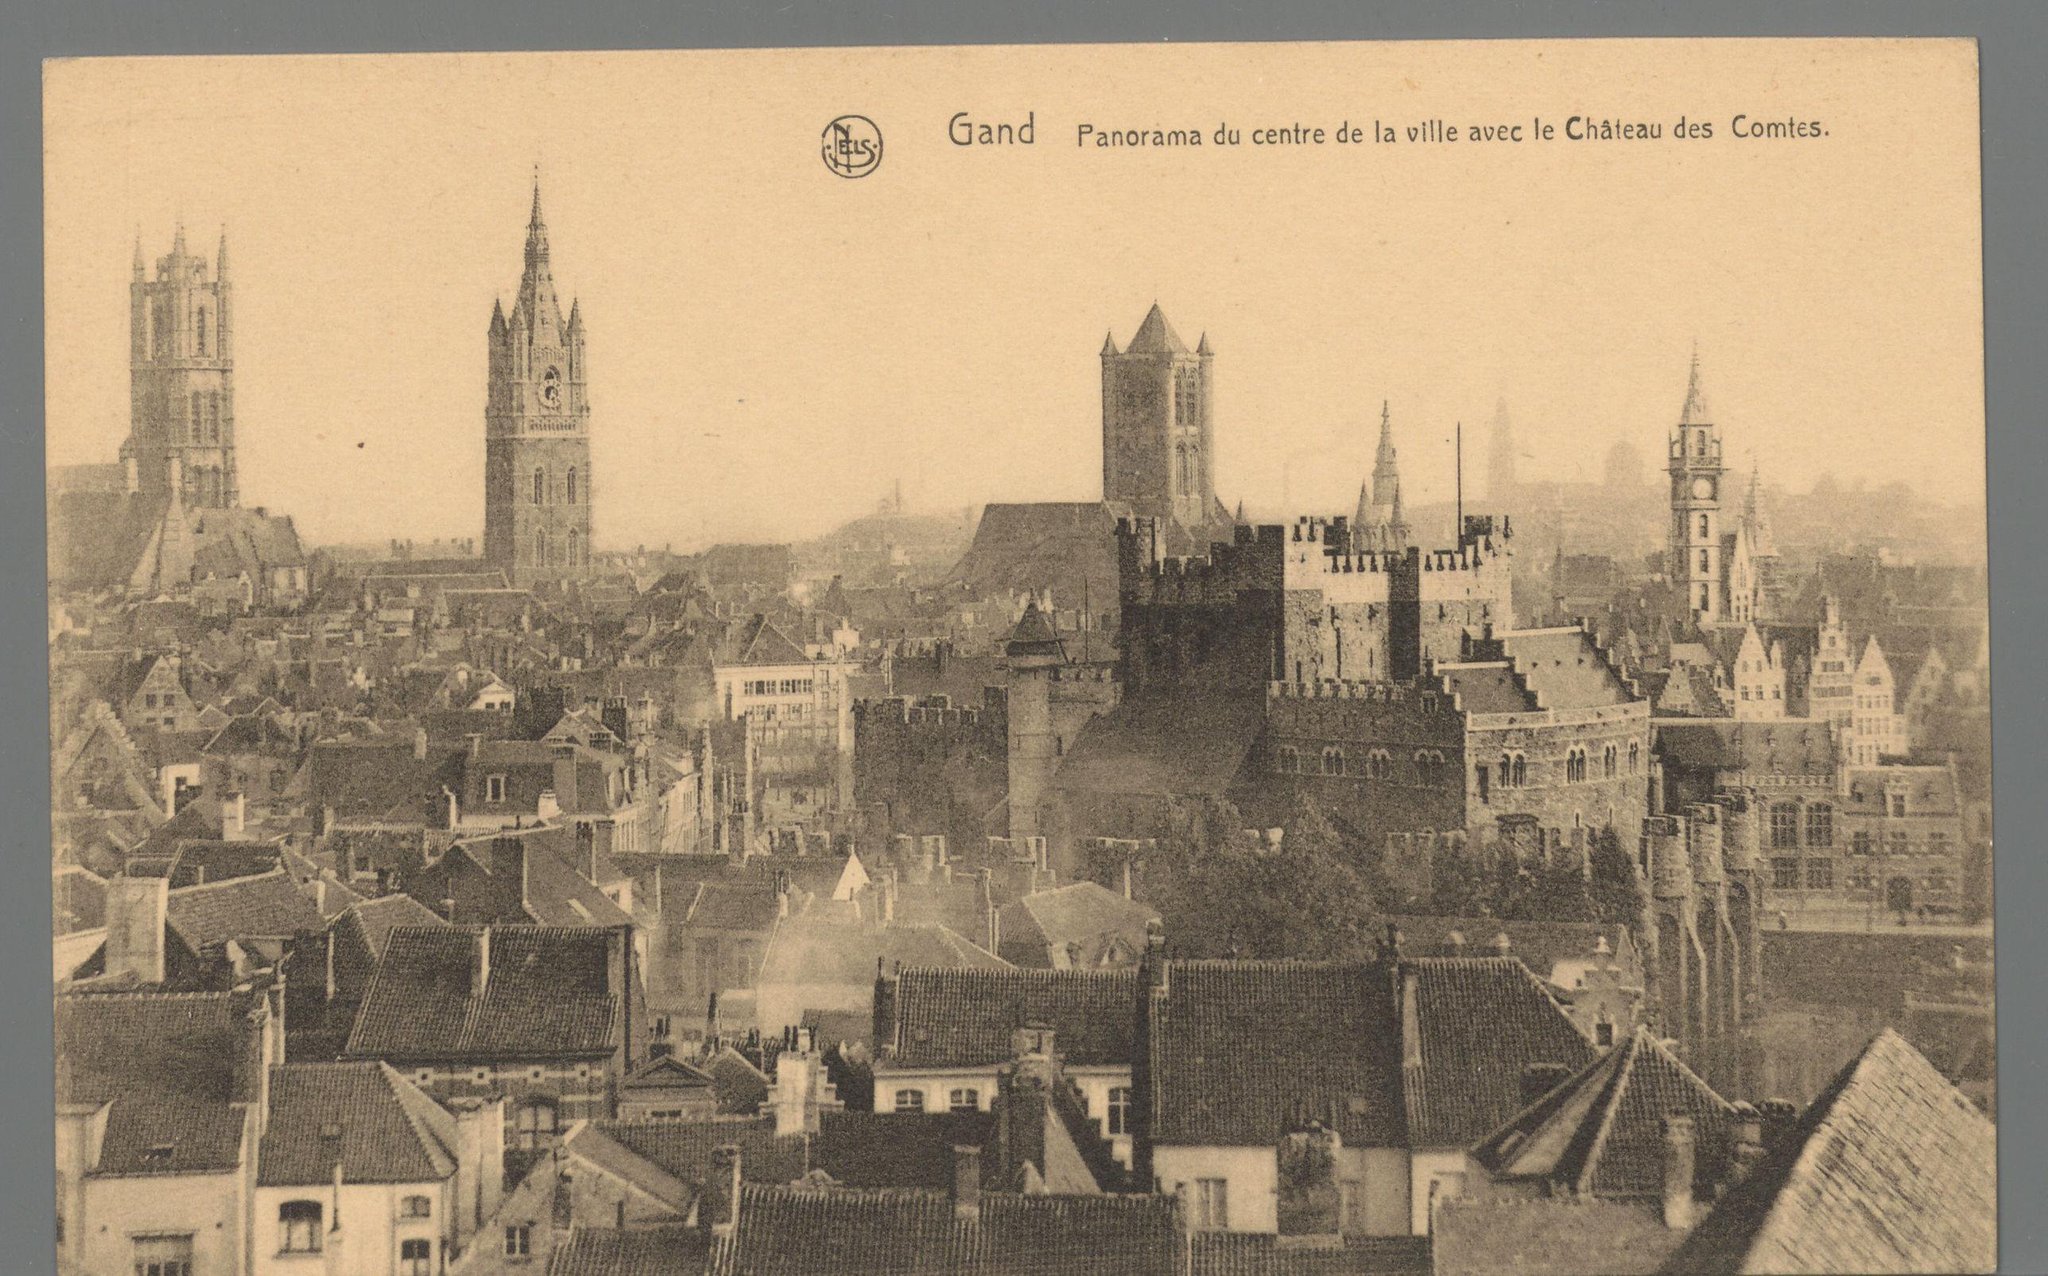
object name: photomechanical print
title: Série 3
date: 1913-1930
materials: cardboard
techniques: photograph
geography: brussels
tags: castle, church (exterior), prospect of city, town panorama, silhouette of city, ghent